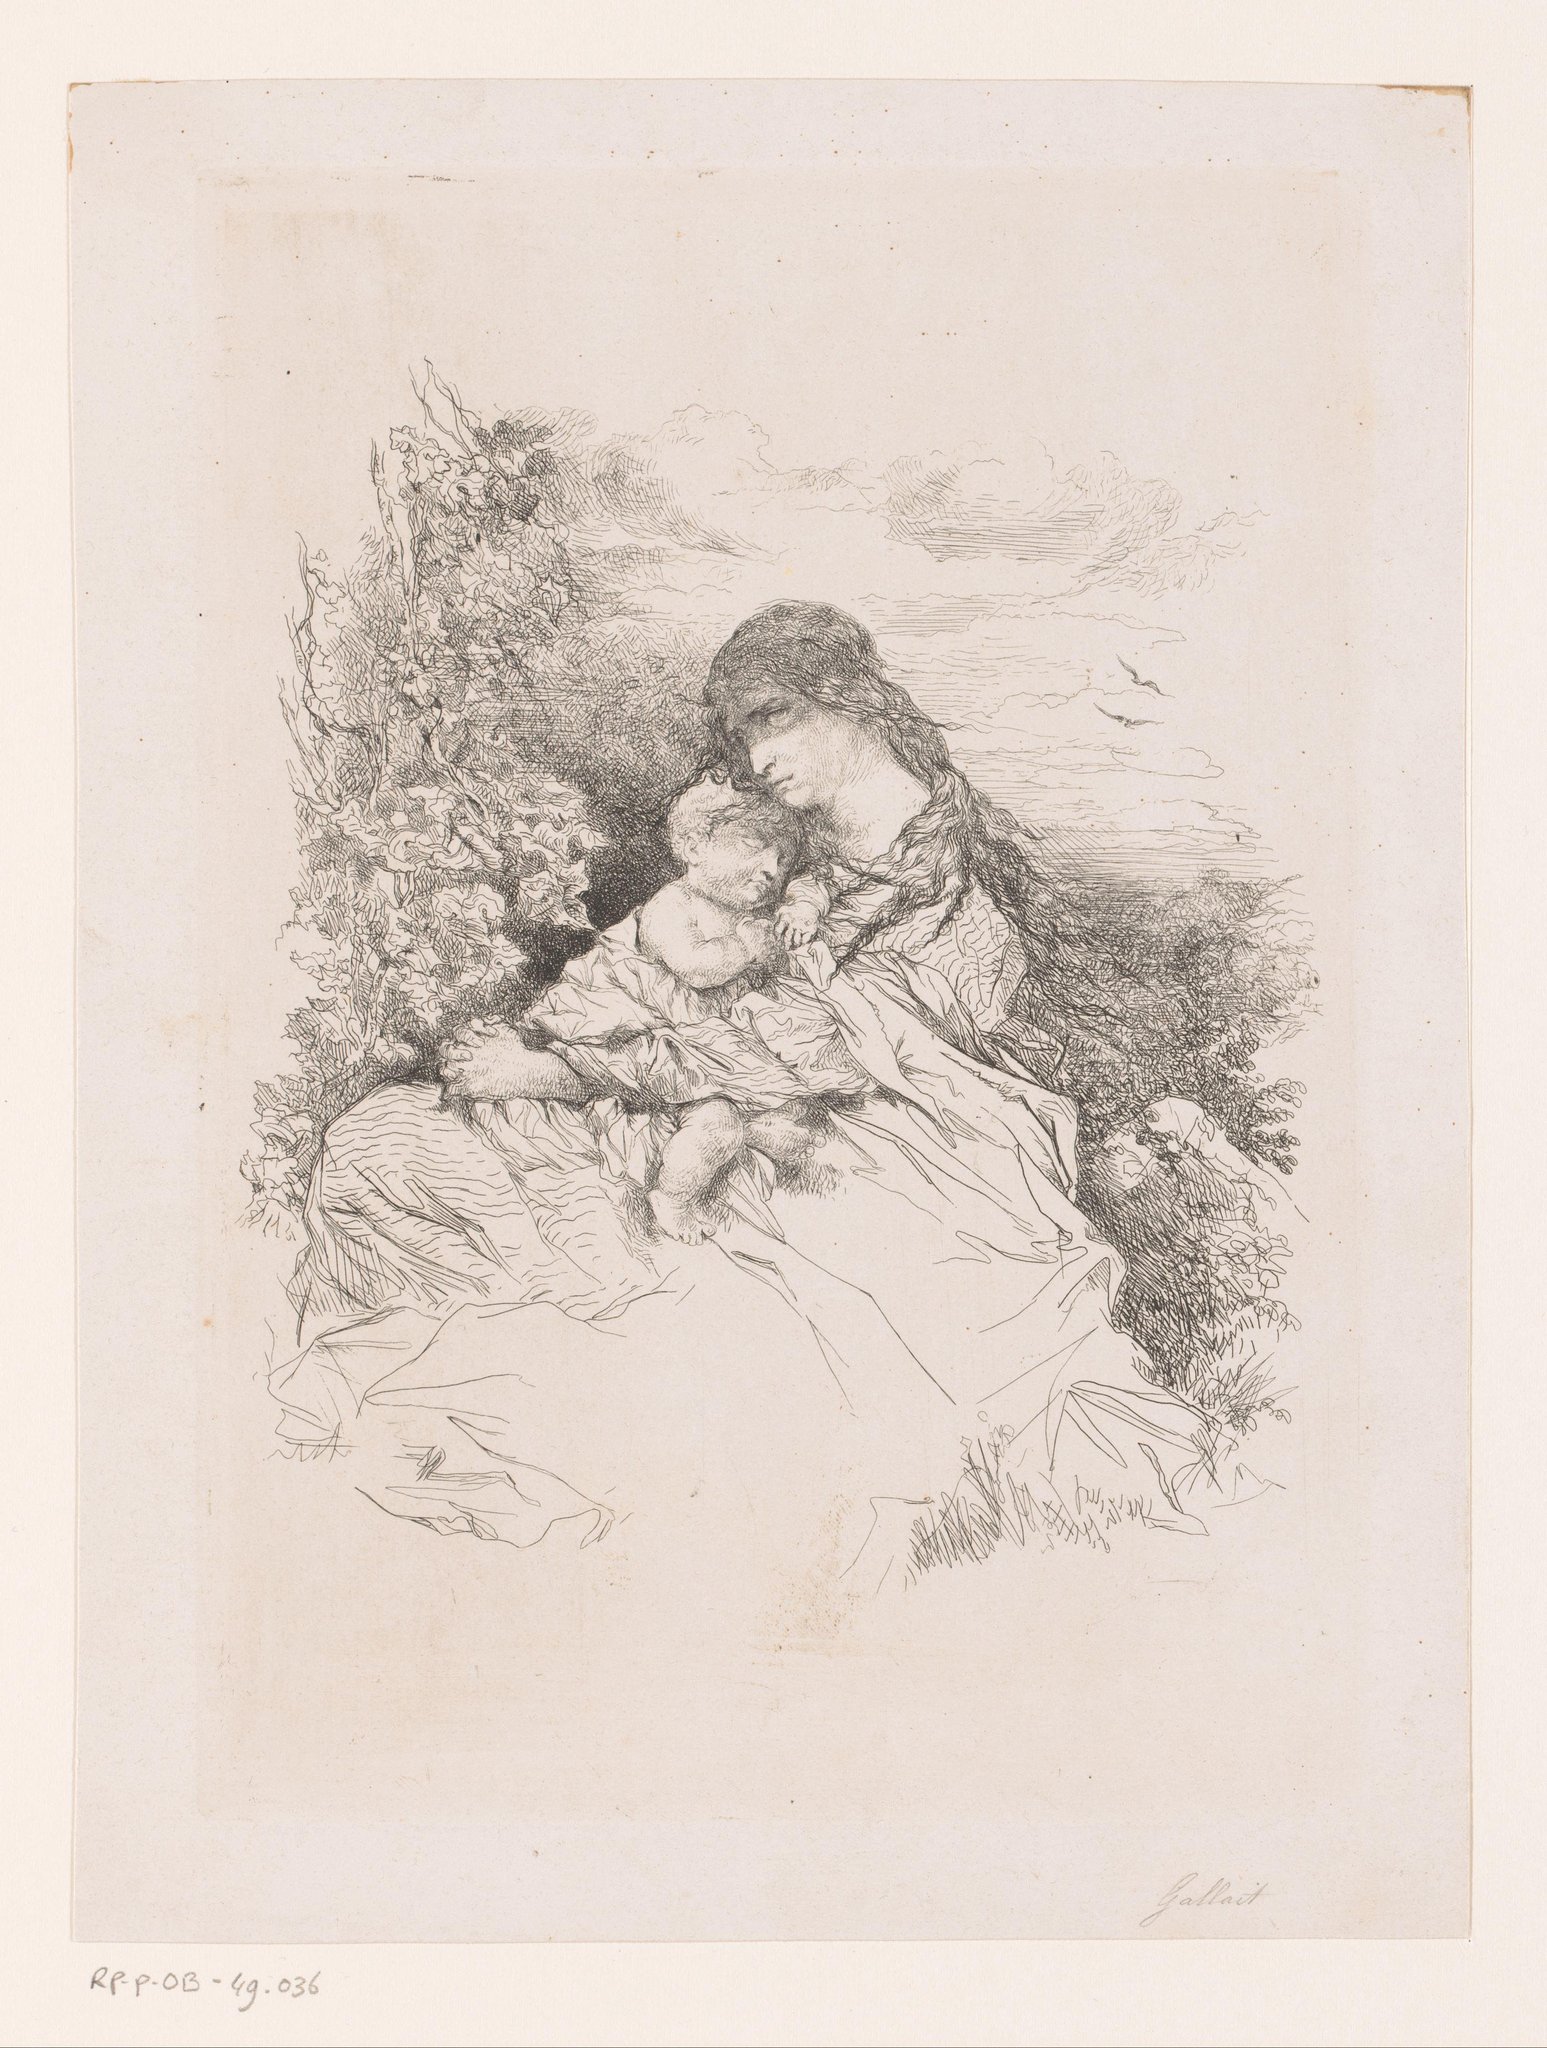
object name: print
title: Moeder met kind gezeten in een landschap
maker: louis gallait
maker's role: draughtsman, painter, print maker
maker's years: 1810-1887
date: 1850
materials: paper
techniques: etching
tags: mother and baby or young child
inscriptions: collector's mark: Lugt 2228